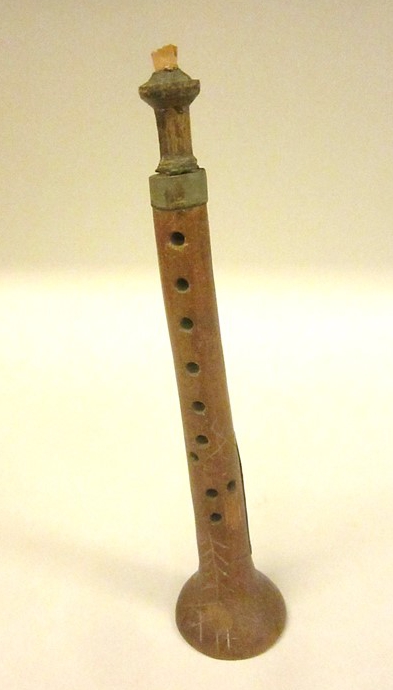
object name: chirimia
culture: chibcha or muysca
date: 1801-1900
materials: cord, metal, rubber, wax, wood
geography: colombia